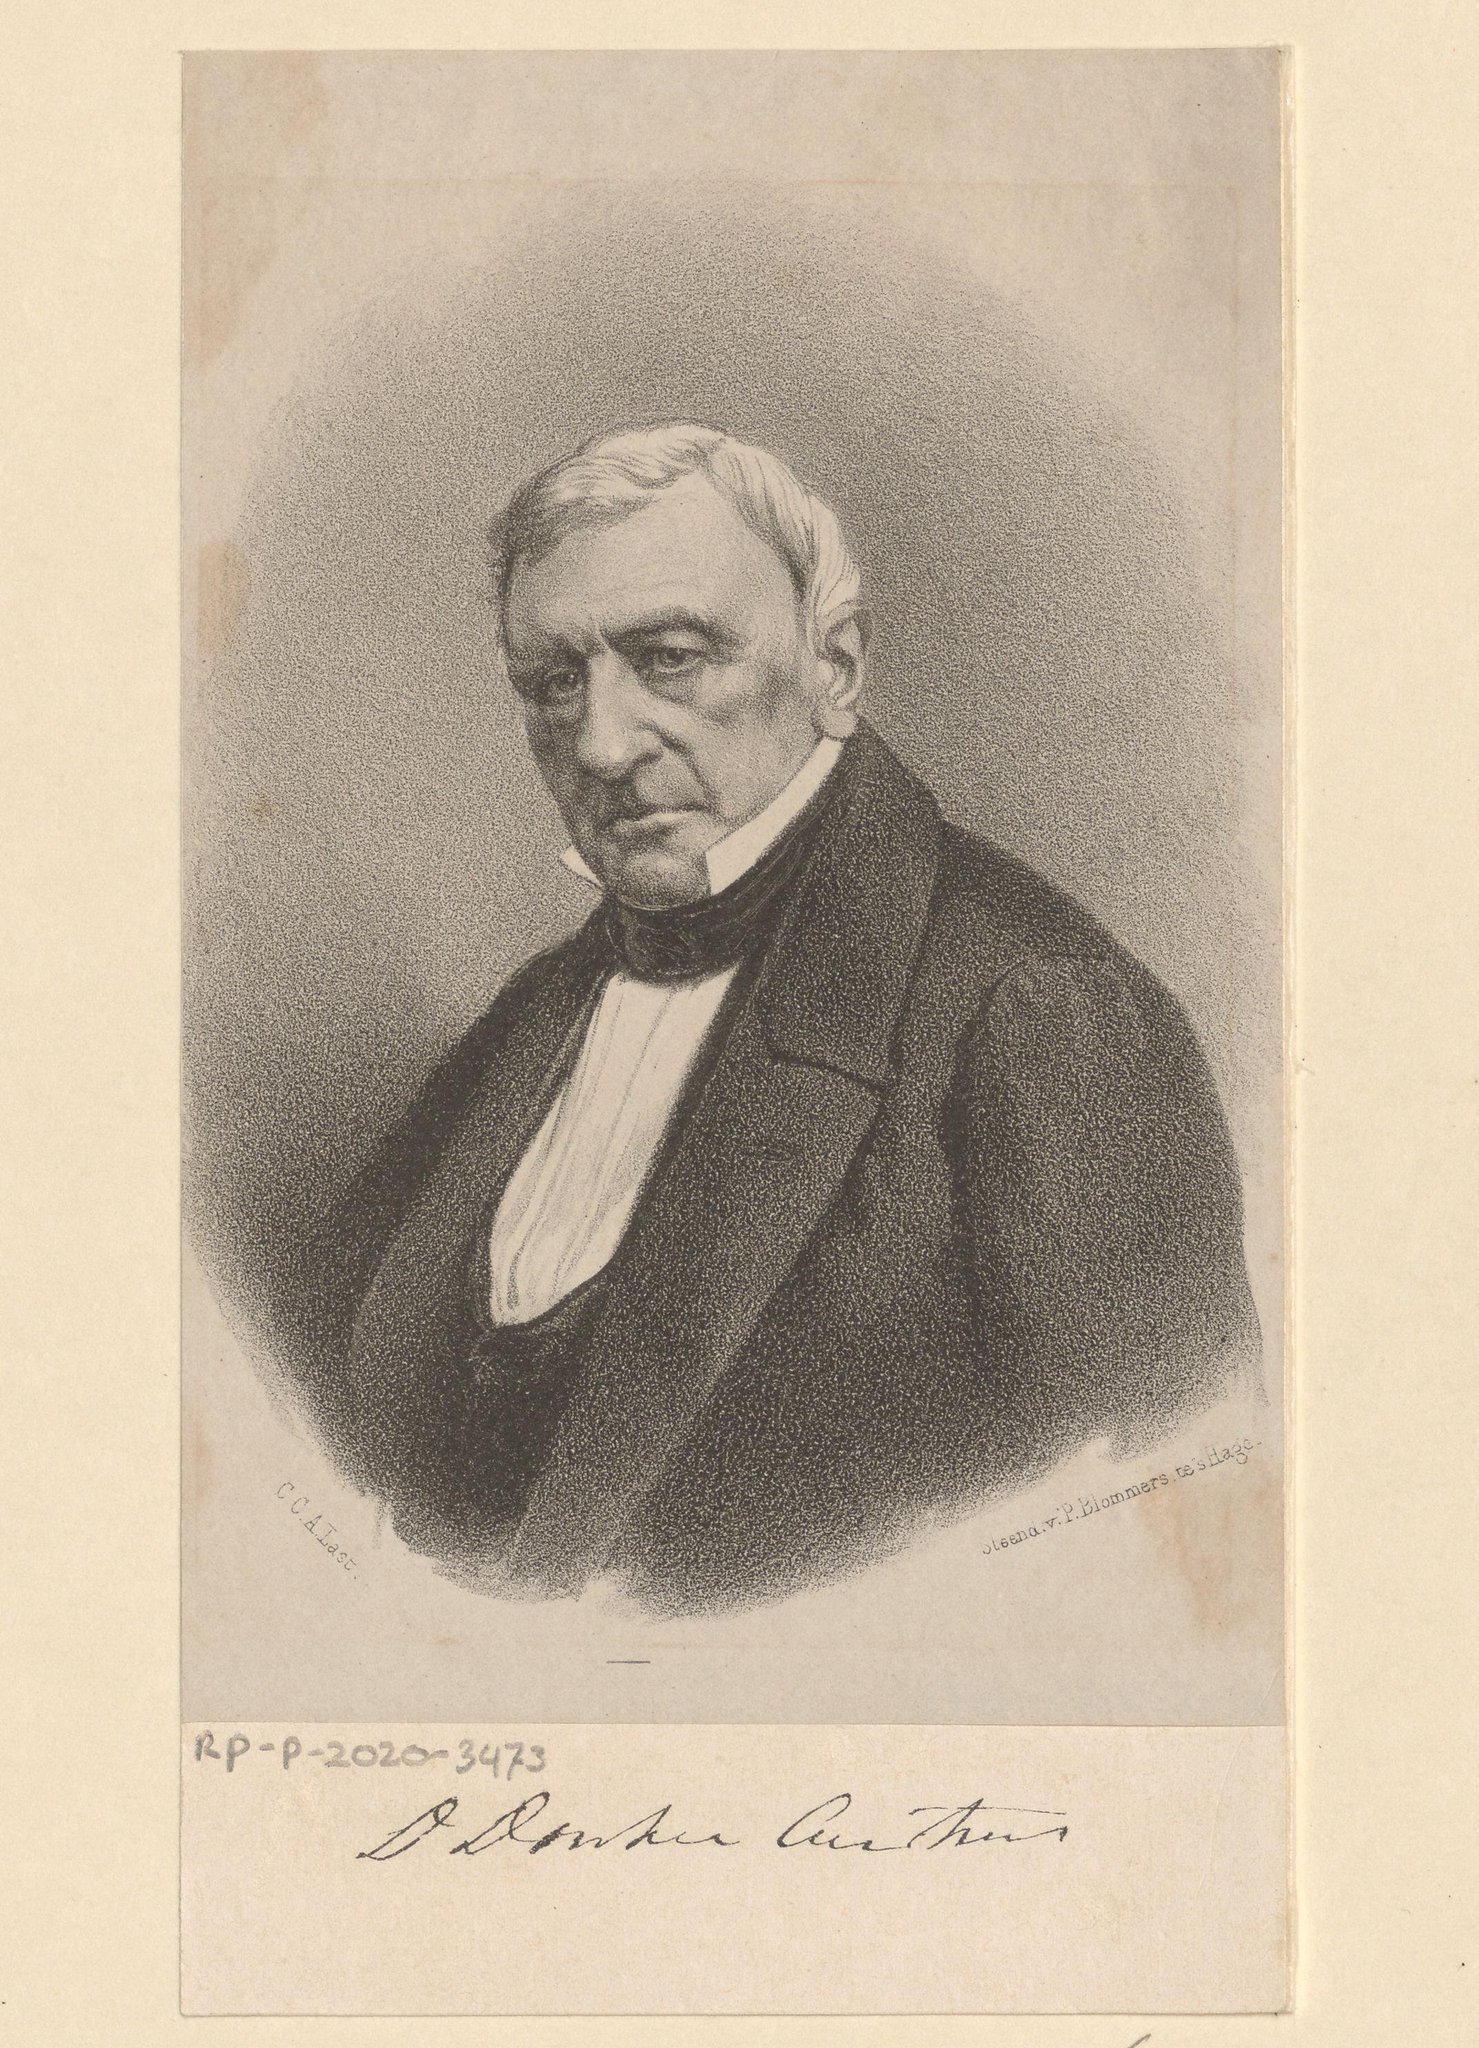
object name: print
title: Portret van Dirk Donker Curtius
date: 1842-1876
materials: paper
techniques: lithograph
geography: the hague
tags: den bosch, historical persons, lawyer, attorney at law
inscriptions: collector's mark: Lugt 2228